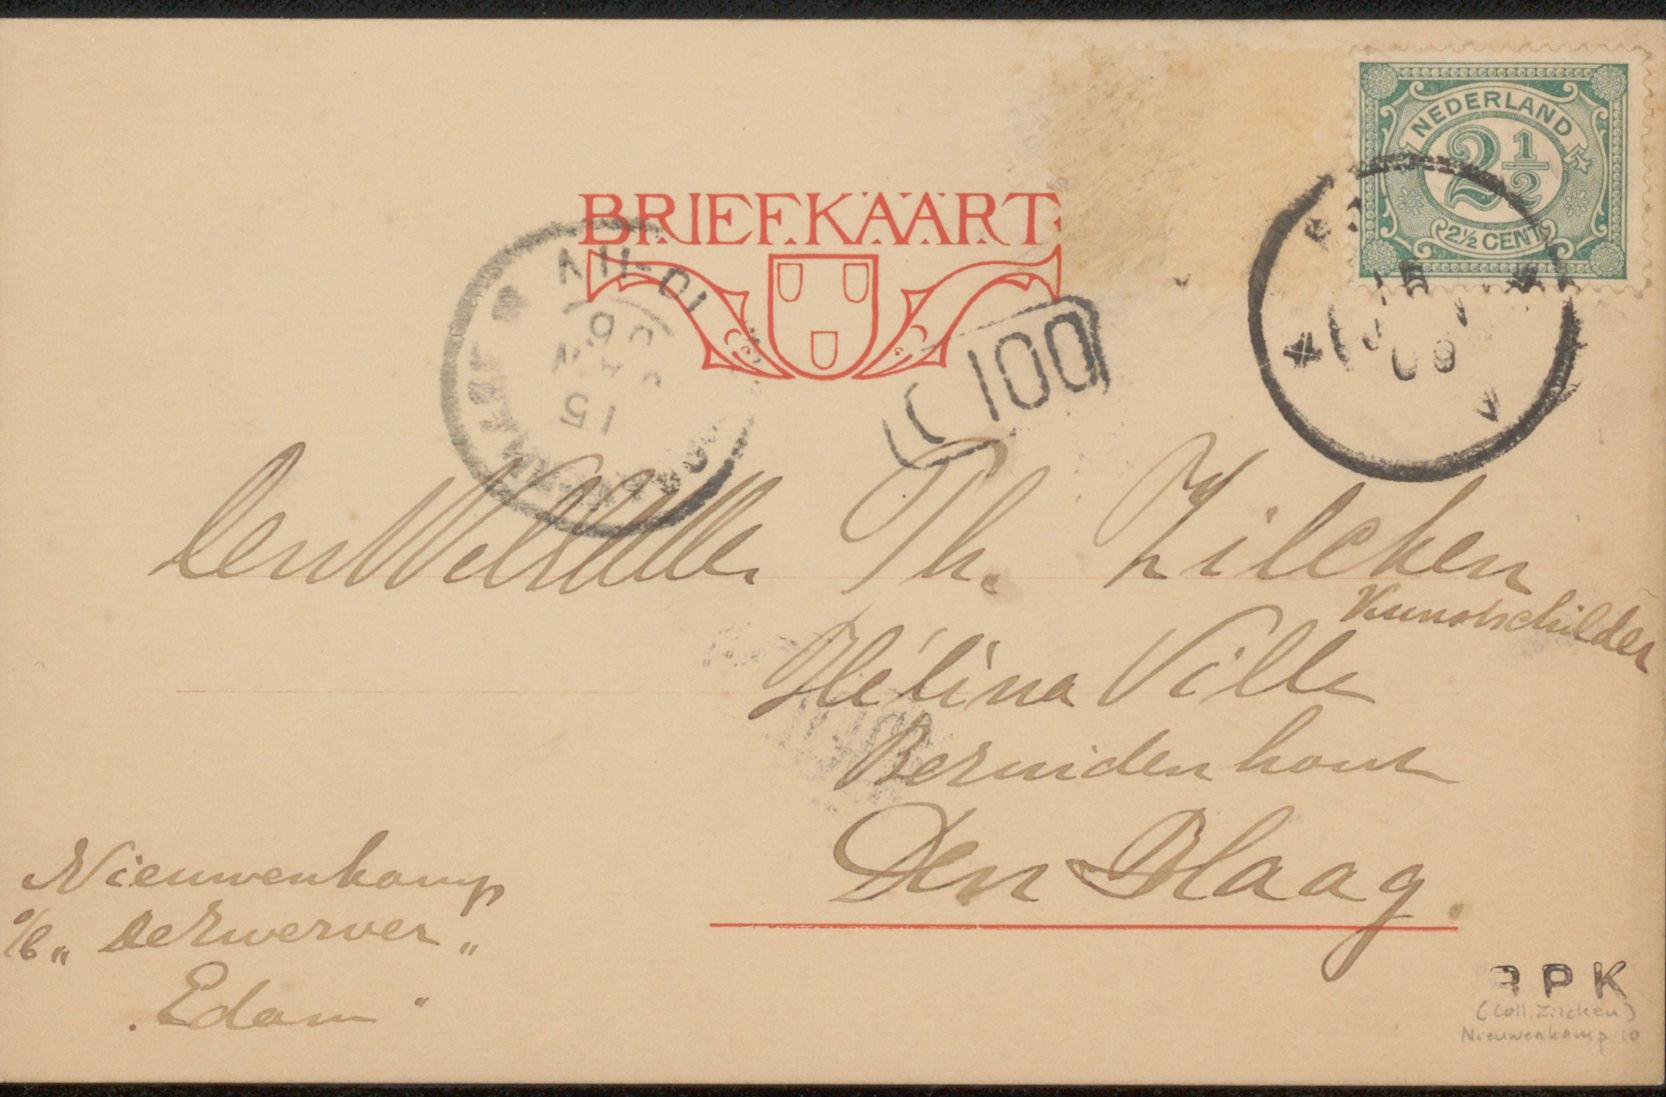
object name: postcard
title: Briefkaart aan Philip Zilcken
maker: wijnand otto jan nieuwenkamp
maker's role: draughtsman, print maker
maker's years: 1874-1950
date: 1906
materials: cardboard, ink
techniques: pen, printing, writing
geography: edam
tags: the hague, draughtsman, philip zilcken, exhibition ~ art, venice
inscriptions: name: ‘RPK’, collector's mark: ‘RPK’